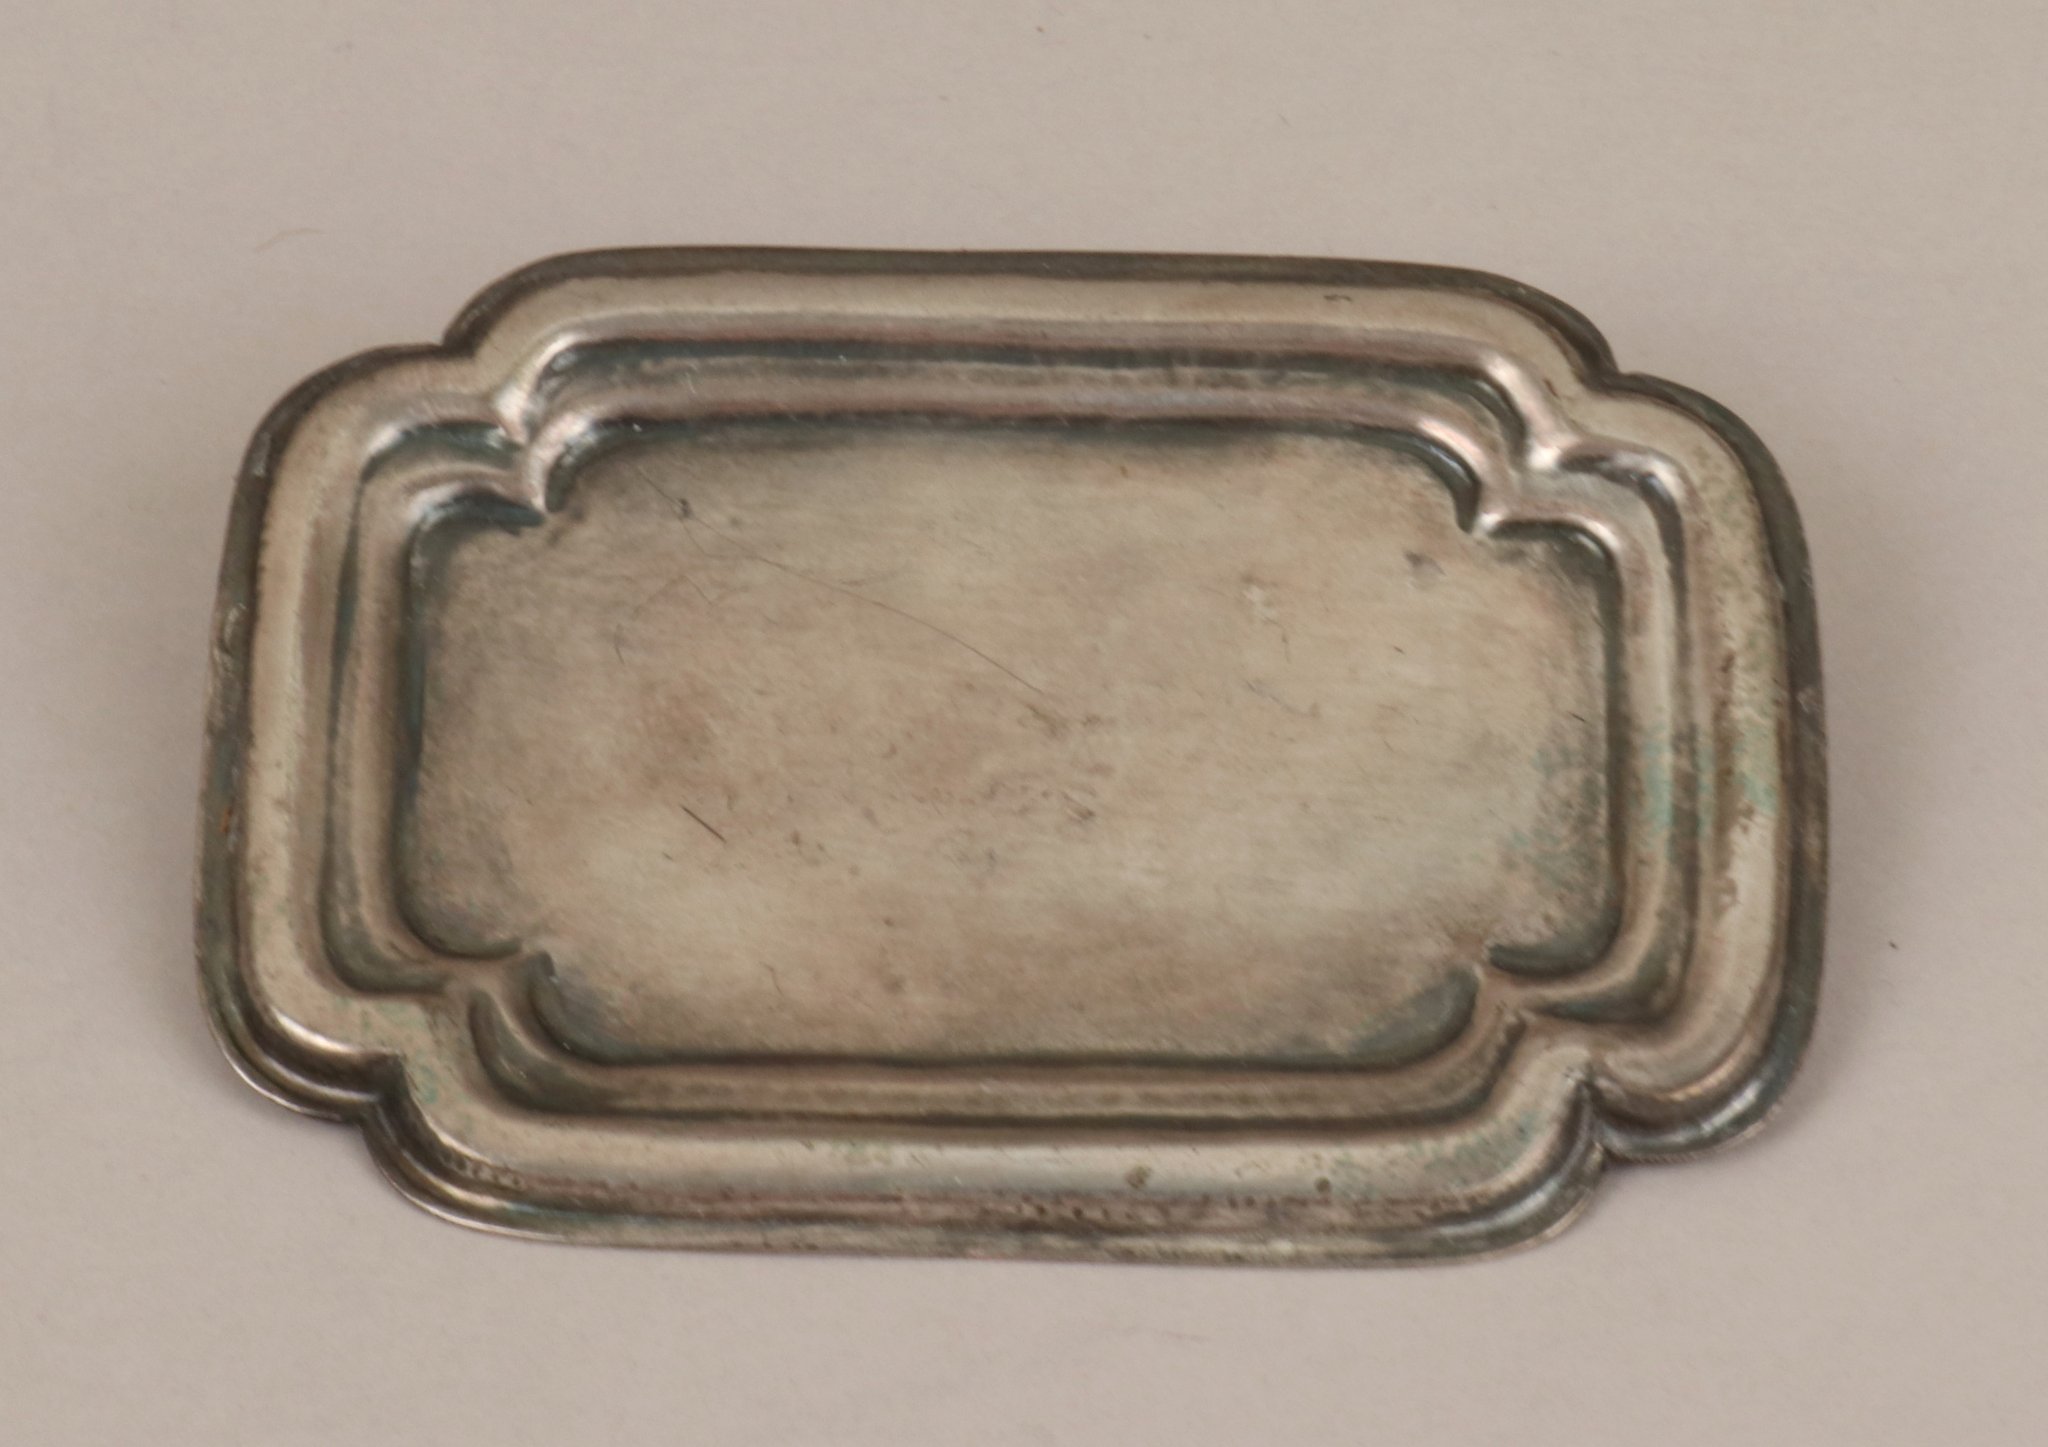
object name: crèche accessory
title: Rectangular pewter platter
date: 1701-1800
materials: pewter